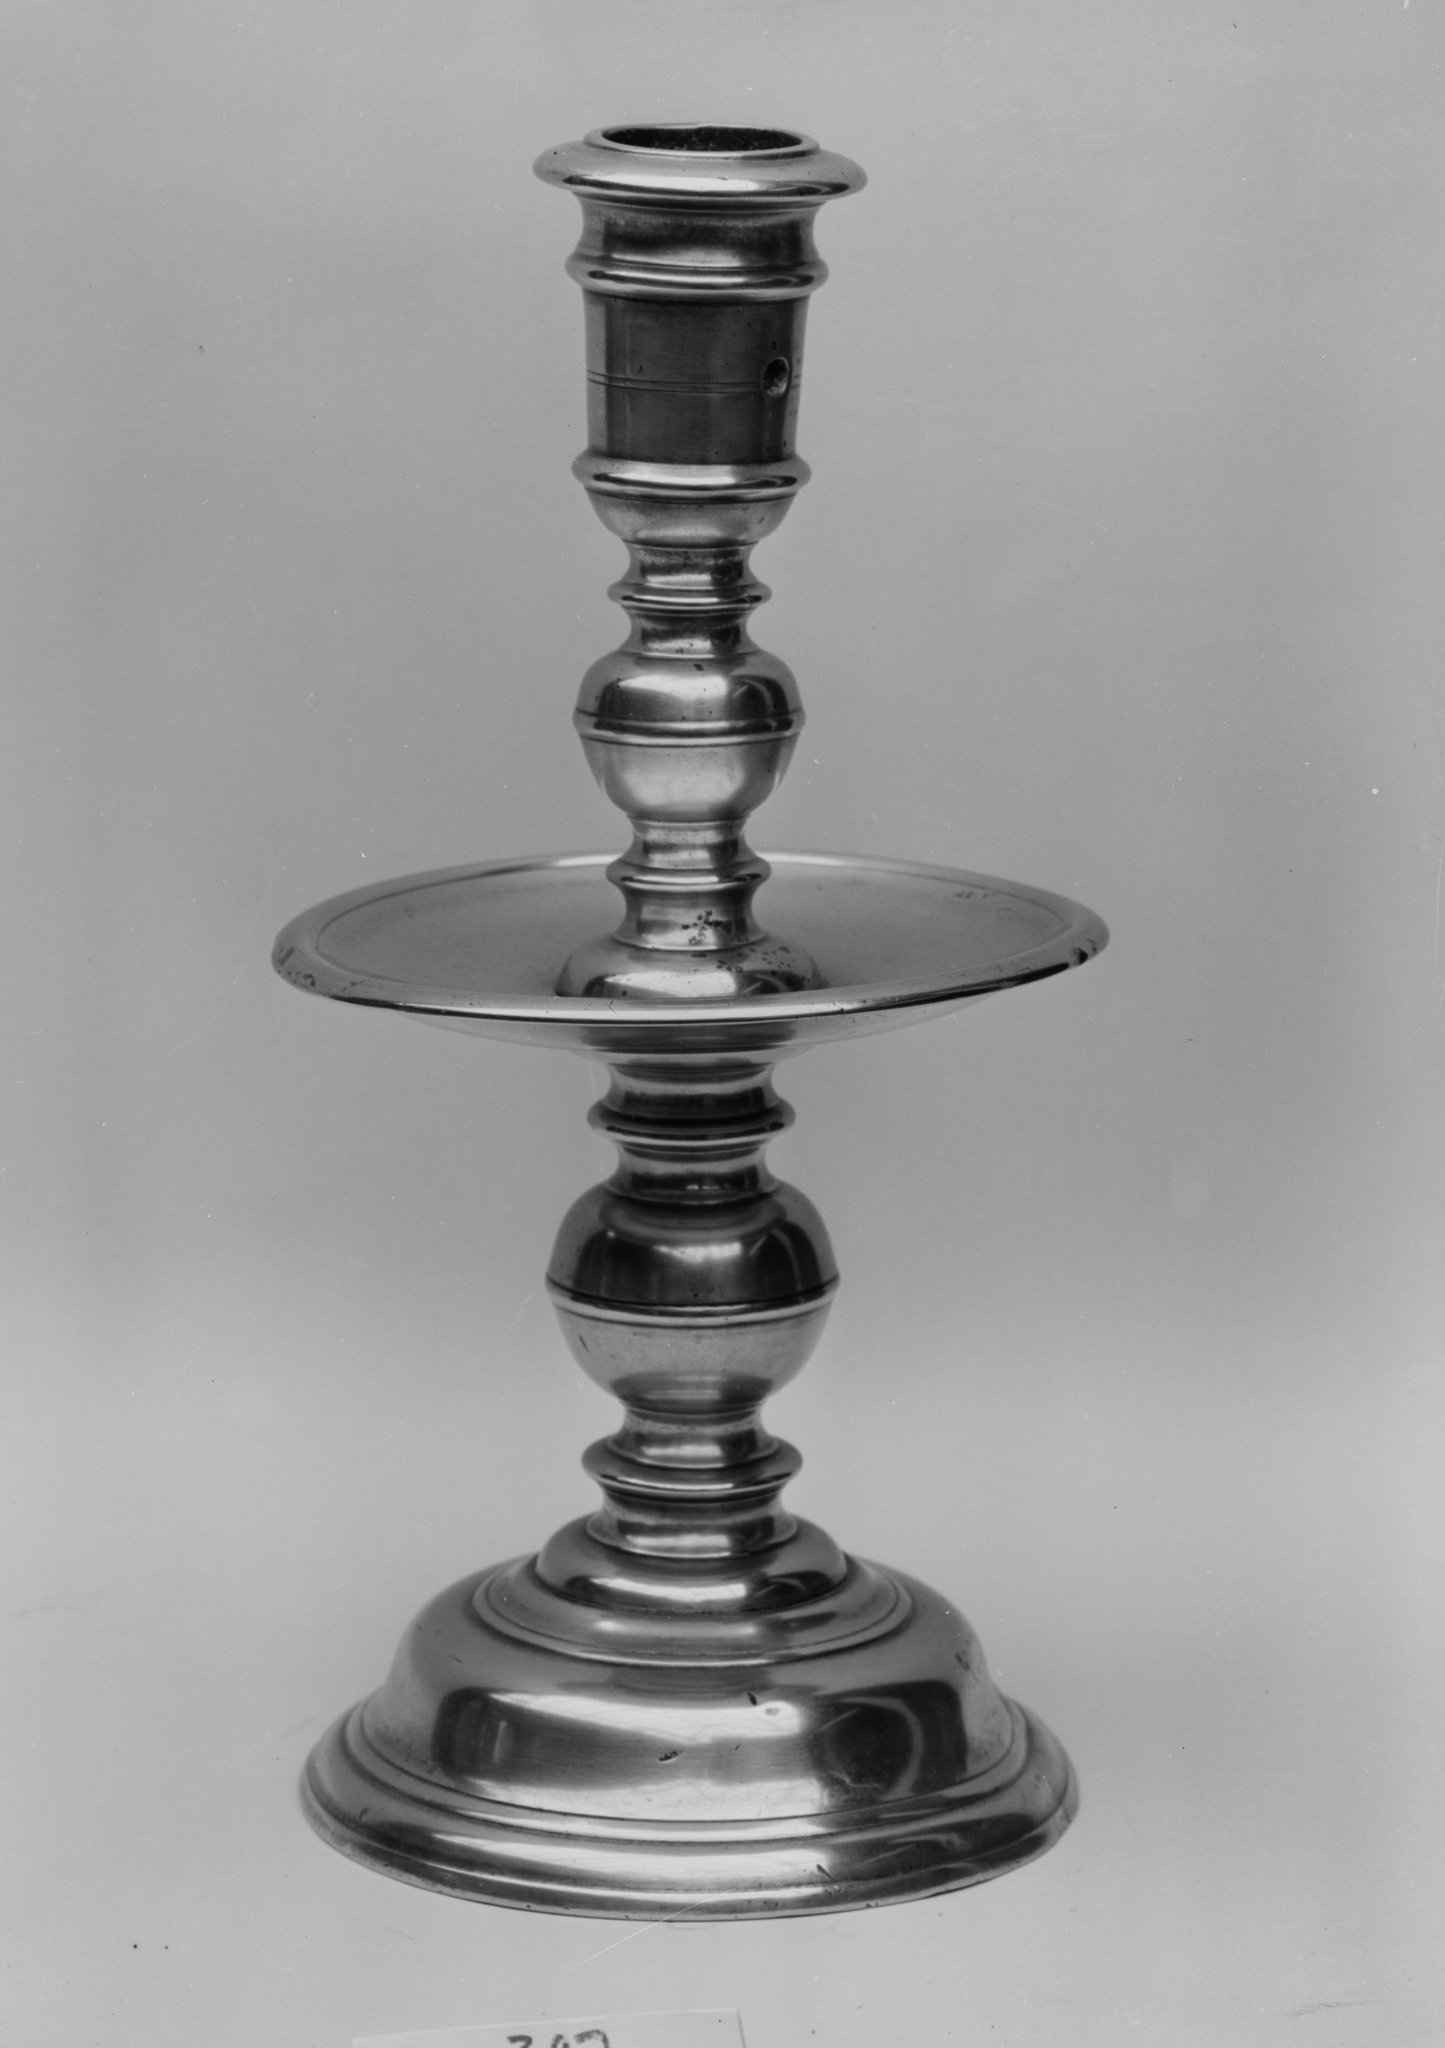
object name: candlestick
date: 1660-1680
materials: brass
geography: england